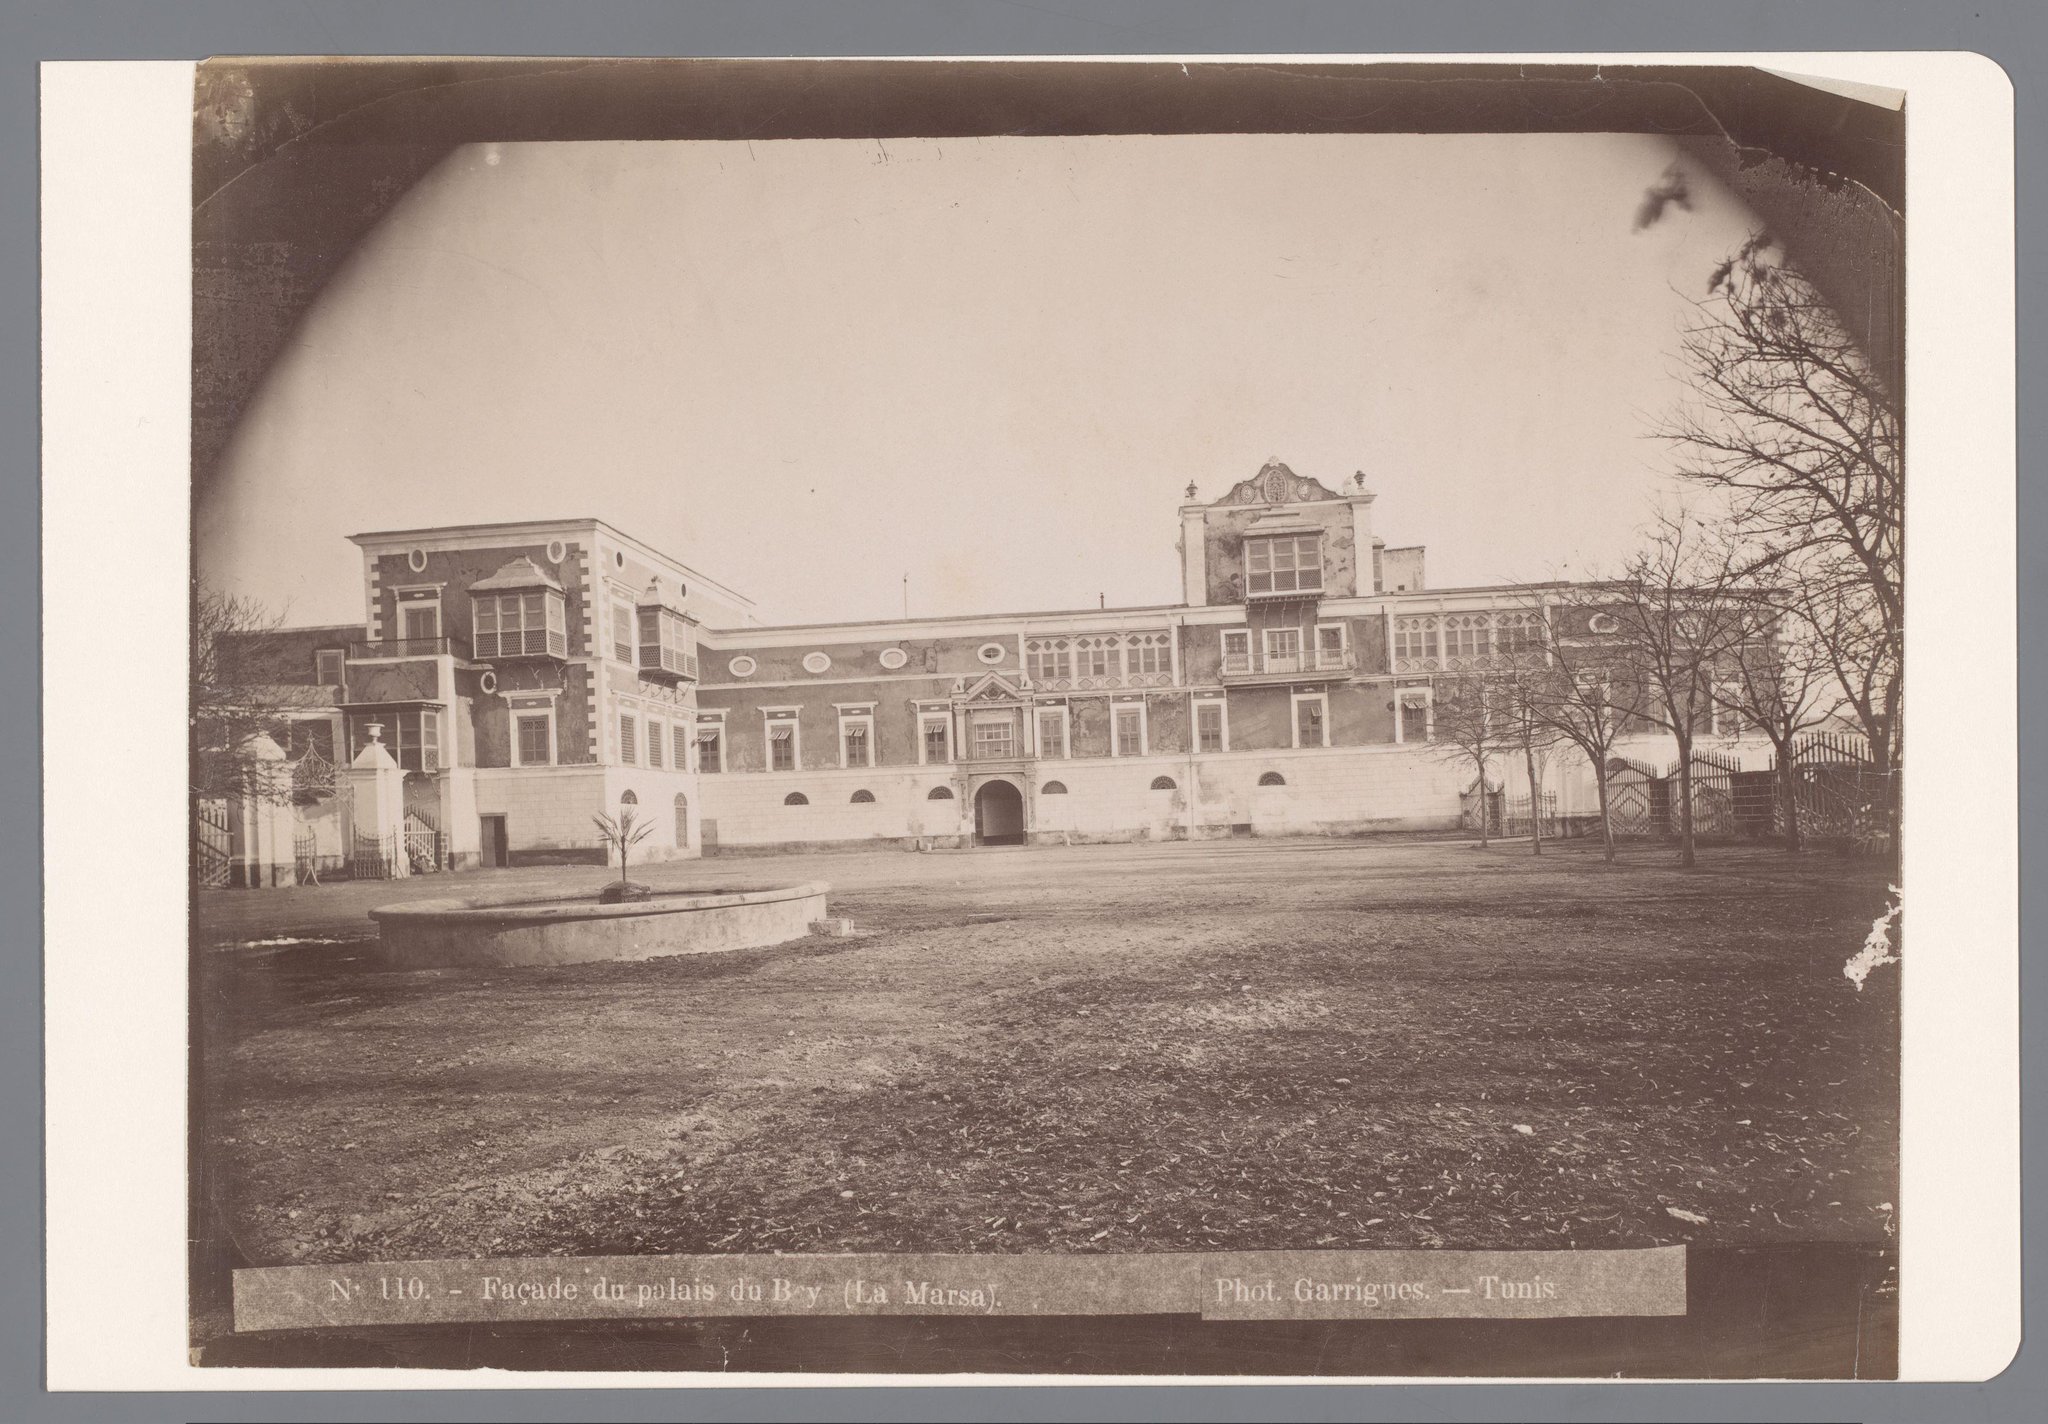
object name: photograph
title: Gezicht op het Dar al-Taj in La Marsa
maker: j. andré garrigues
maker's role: fotograaf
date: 1860-1900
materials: paper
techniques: albumen print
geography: la marsa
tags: palace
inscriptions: number: ‘N. 110.’